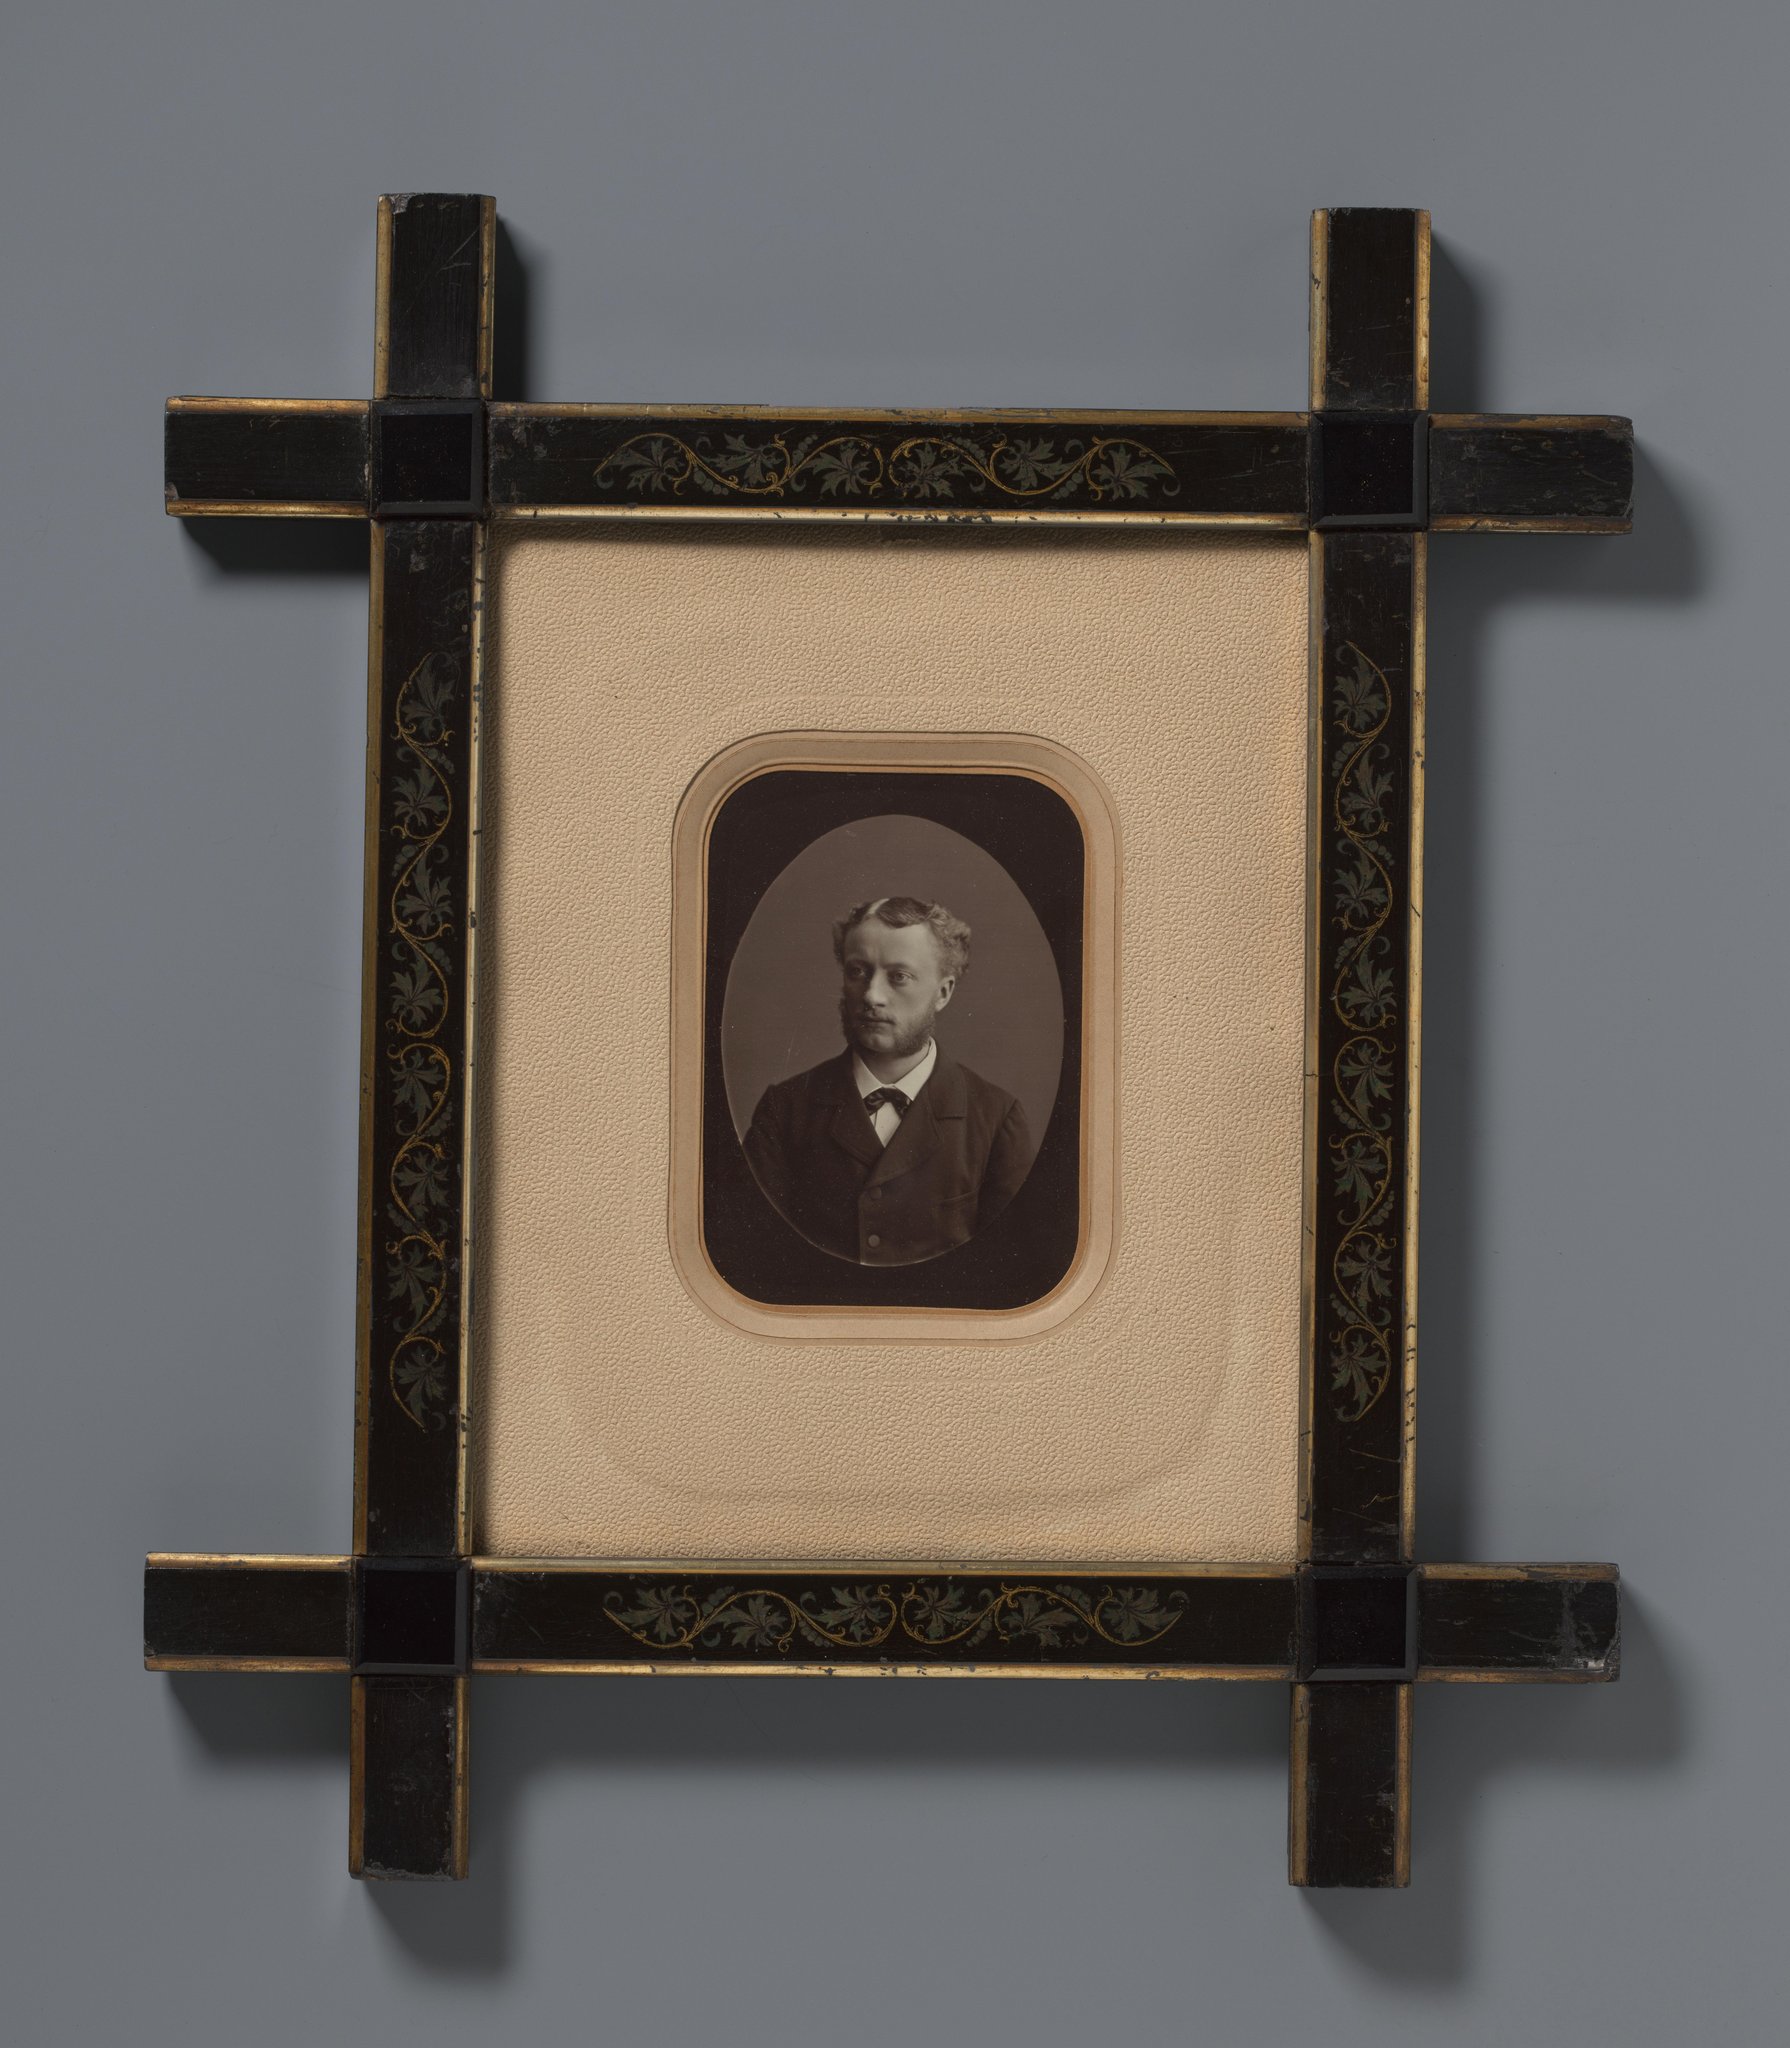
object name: frame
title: Portret van een onbekende jongeman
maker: Anonymous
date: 1897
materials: cardboard, celluloid, glass, metal, paper, wood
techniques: albumen print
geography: netherlands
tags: historical persons not known by name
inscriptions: label: ‘M. Hartmann/ Utrechtschestraat, 14/ Spiegels/ en lijsten/ fabriek./ Galeries/ Magazijn van staalgravuren.’